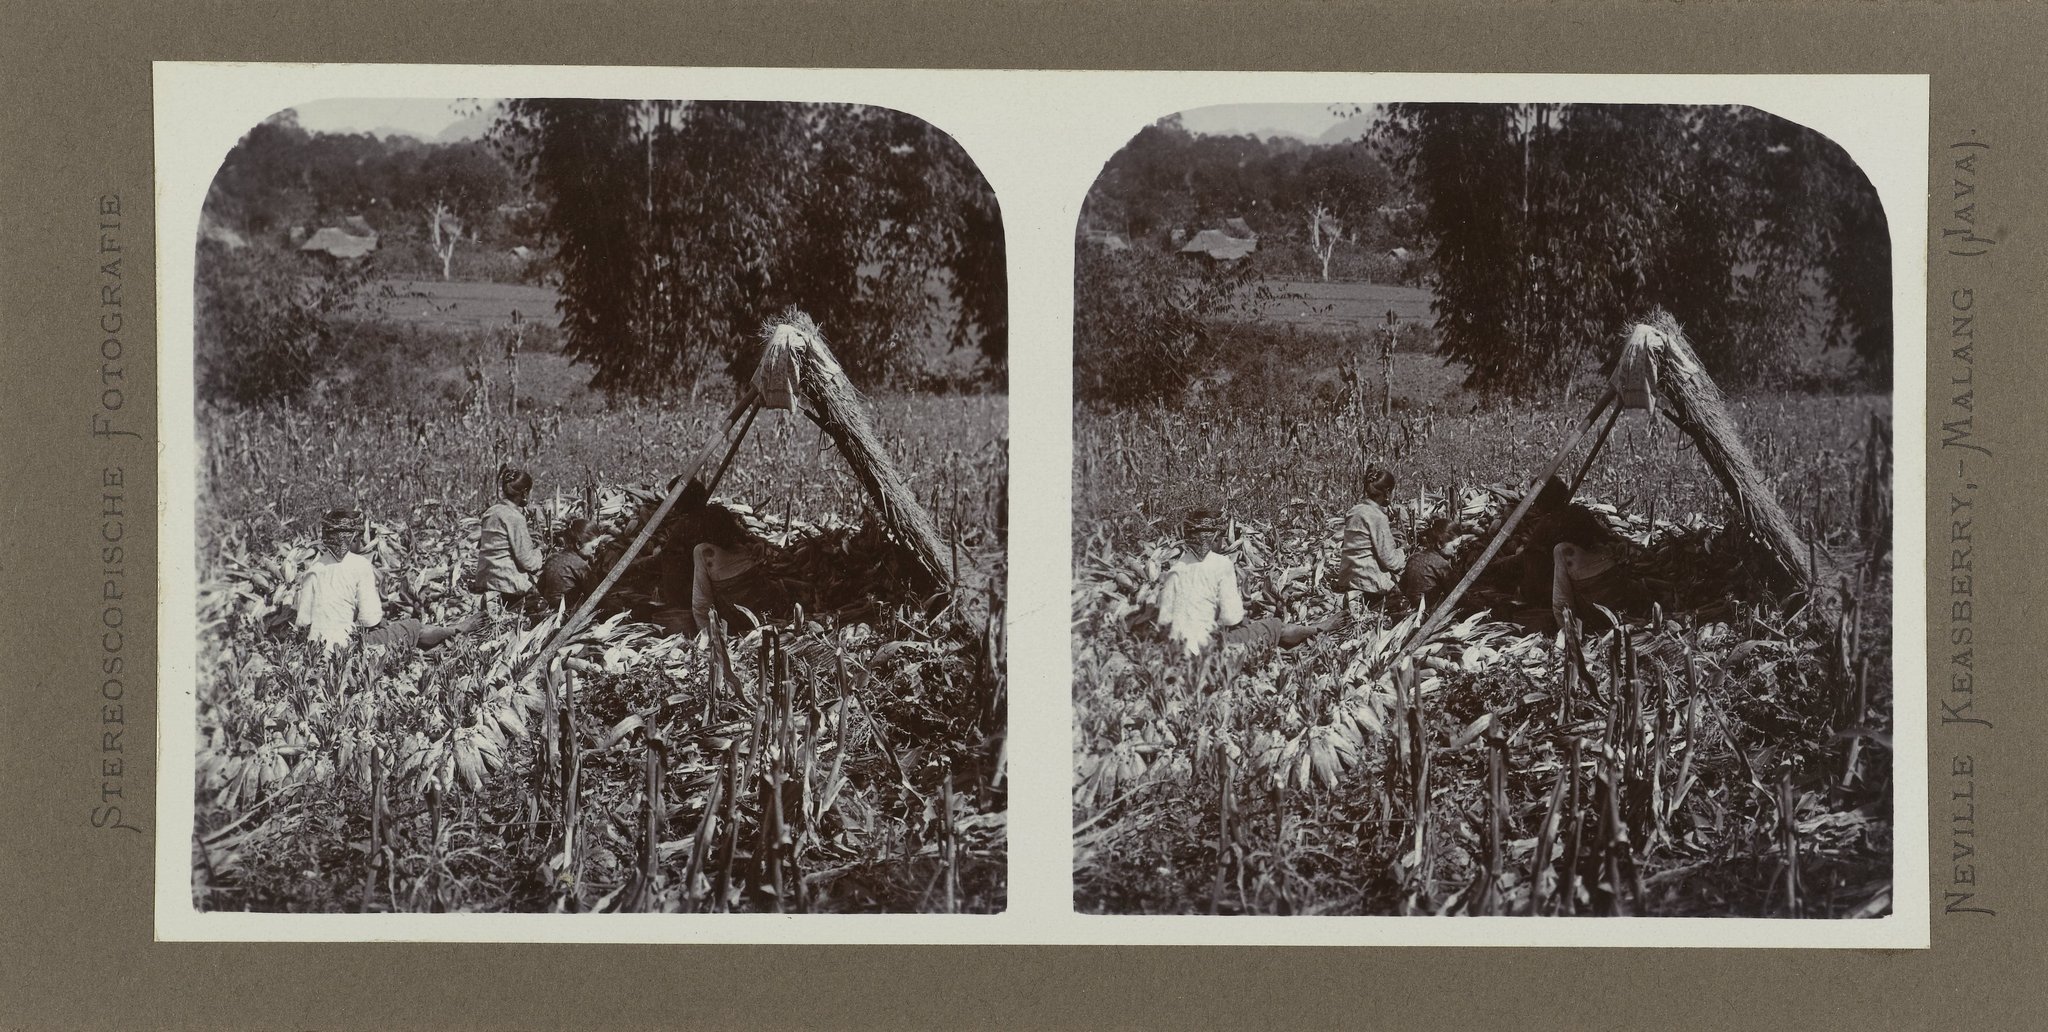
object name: stereograph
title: S 7 No 77. Het oogsten van djagoong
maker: neville keasberry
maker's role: fotograaf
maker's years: 1866-1944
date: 1900-1935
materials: cardboard, paper, photographic support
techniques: albumen print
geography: malang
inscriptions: signature: ‘Neville Keasberry, Malang (Java)’, inscription: ‘Stereoscopische Fotografie’